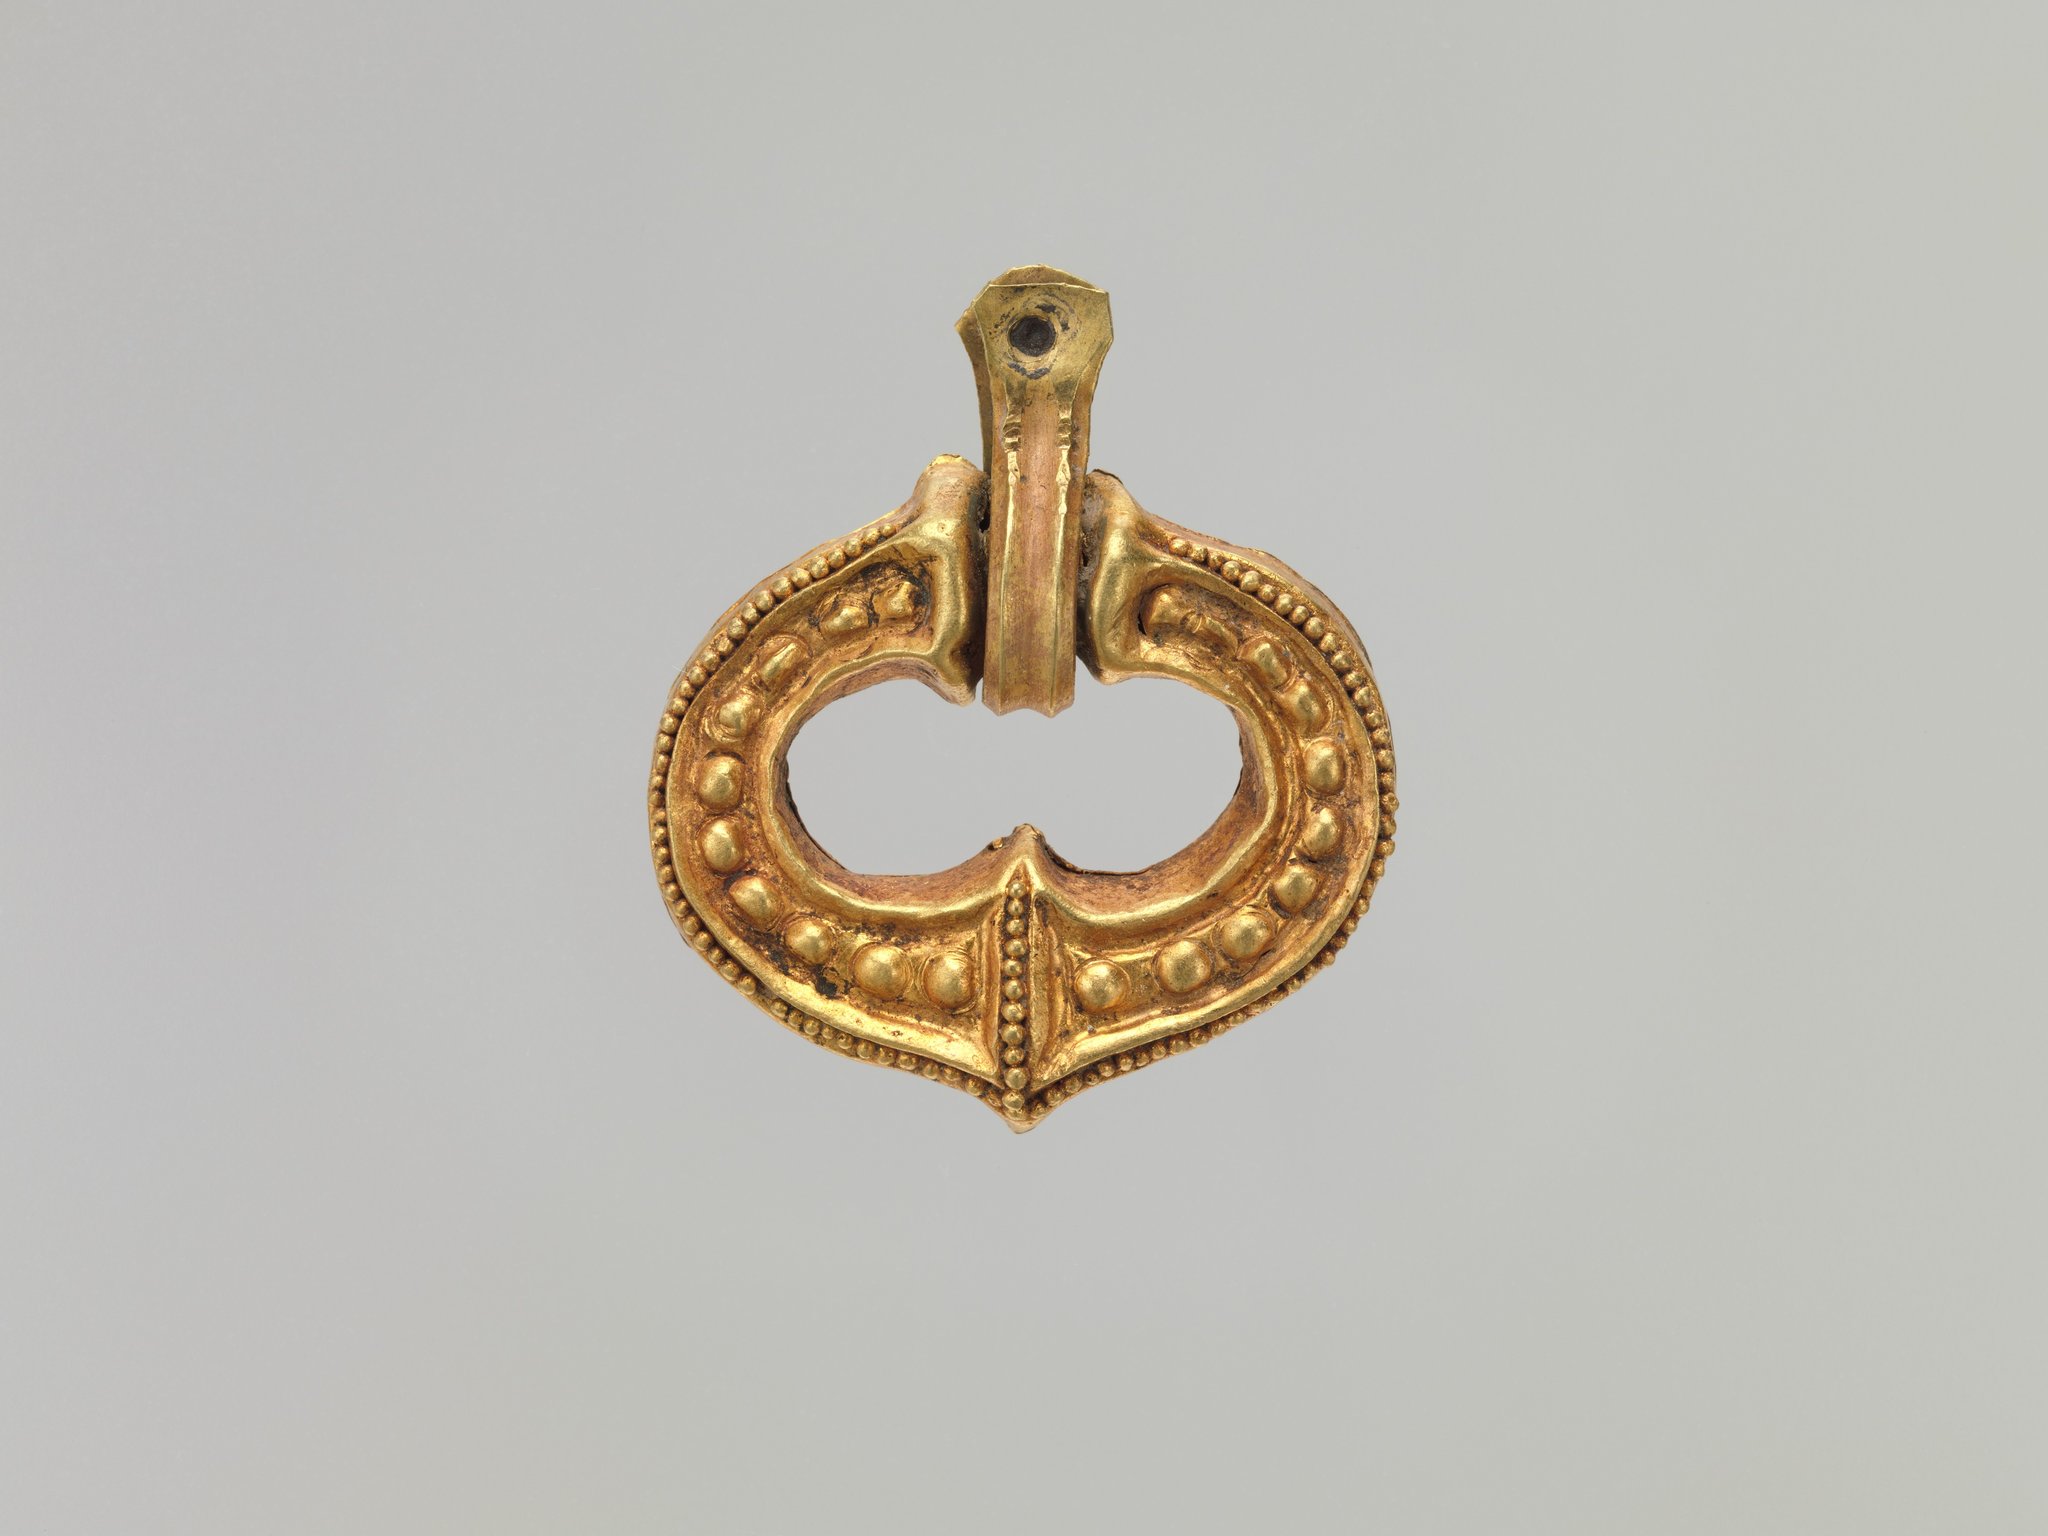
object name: suspension ring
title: Decorated Fitting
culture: chinese or central asian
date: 601-900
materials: gold